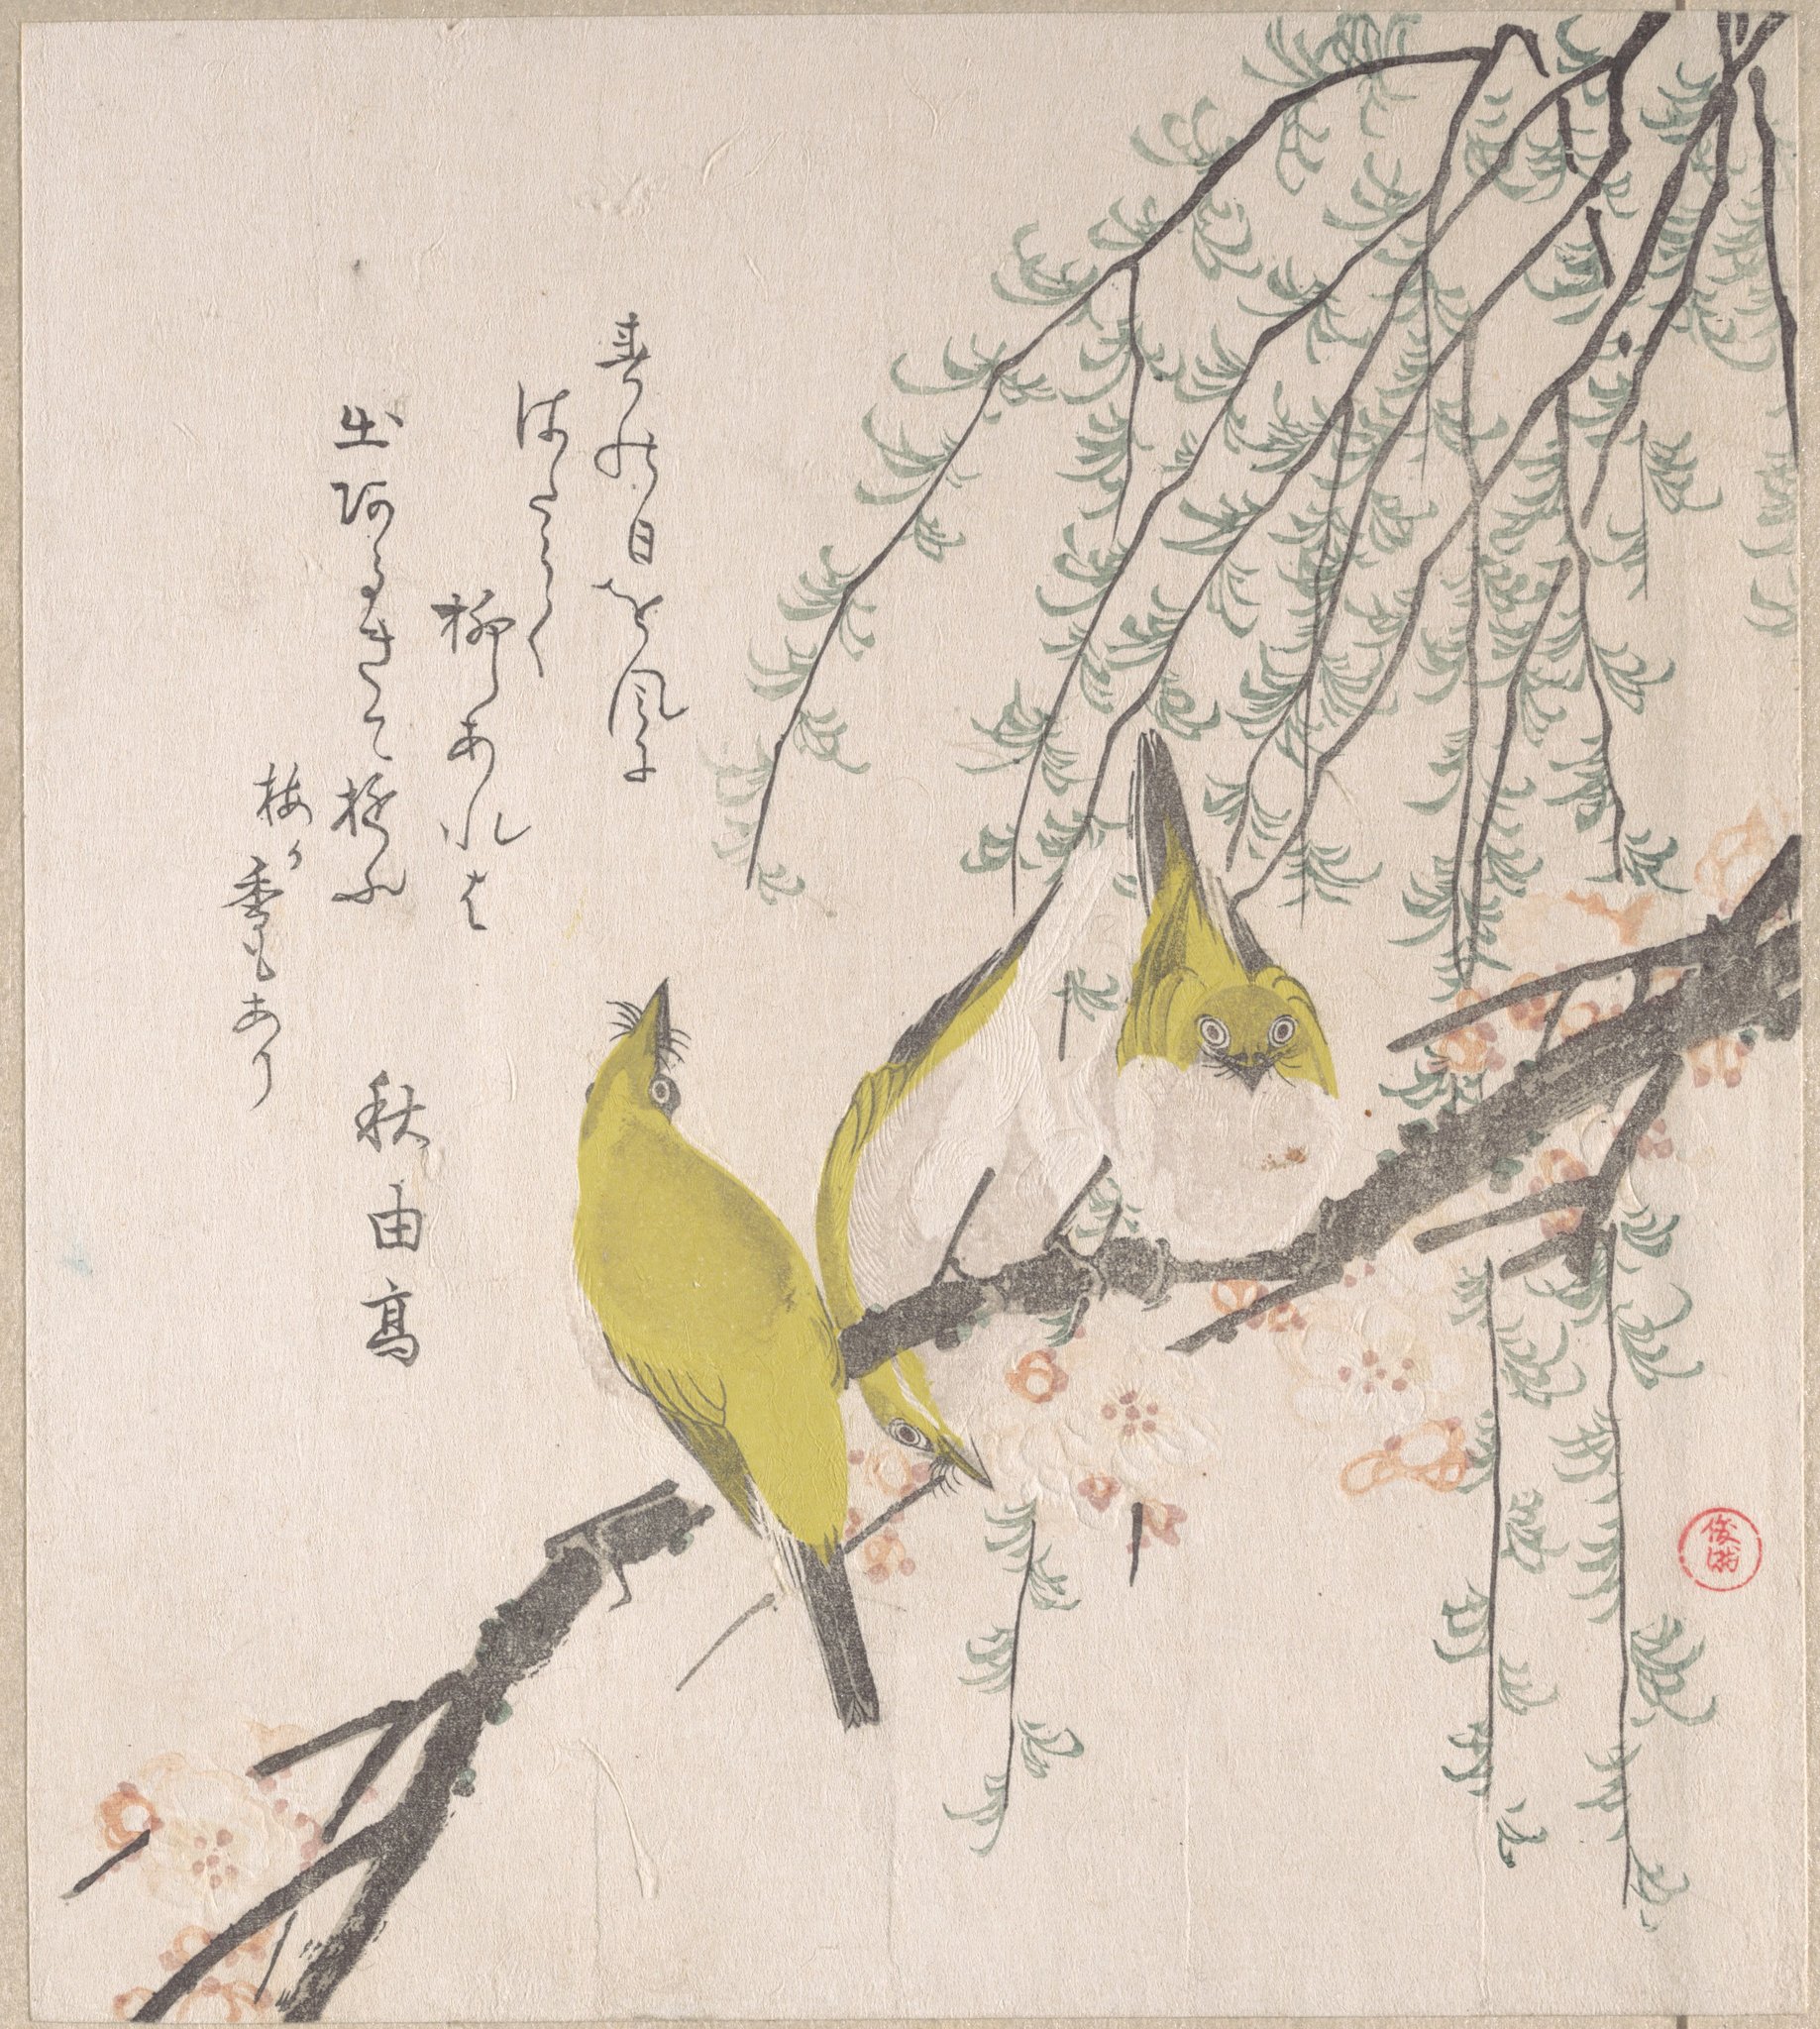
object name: woodblock print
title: Japanese White-eyes with Plum Tree and Willow, from Spring Rain Surimono Album (Harusame surimono-jō, vol. 3)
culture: japanese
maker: kubo shunman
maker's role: artist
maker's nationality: japanese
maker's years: 1757-1820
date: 1810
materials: ink, paper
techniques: surimono, woodblock print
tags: birds,trees